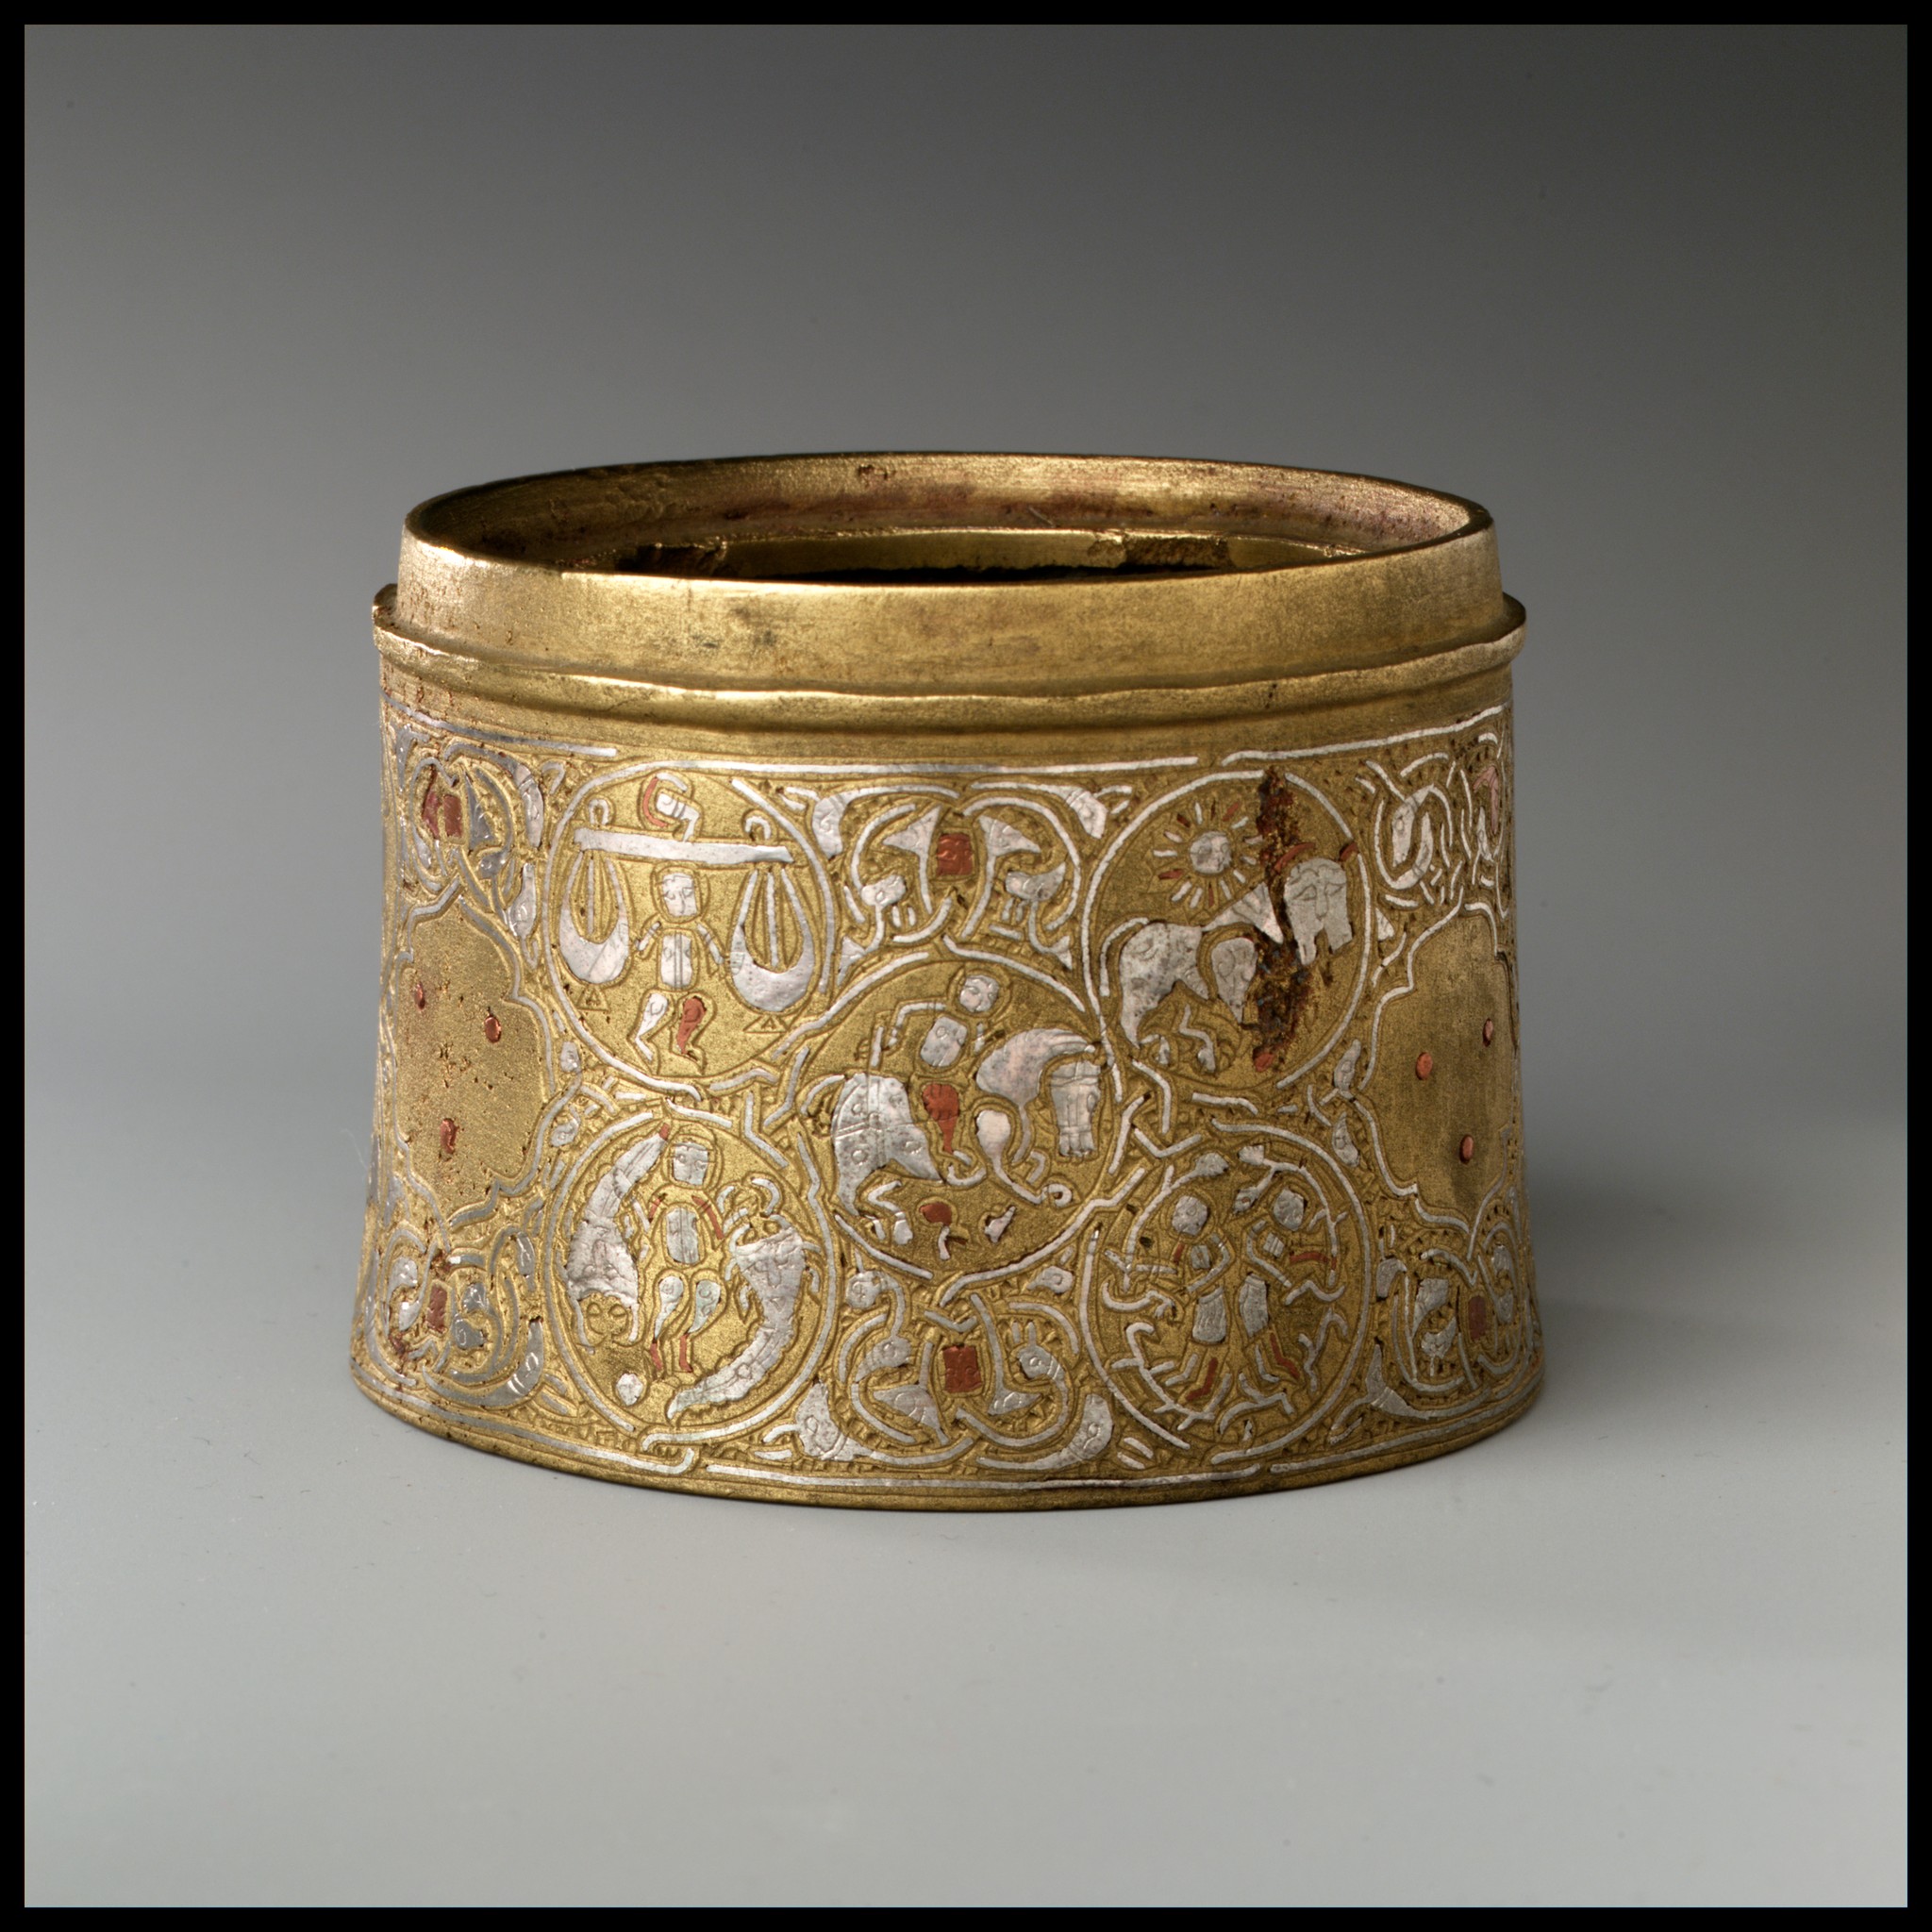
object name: inkwell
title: Inkwell with Twelve Zodiac Medallions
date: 1167-1233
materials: brass, copper, silver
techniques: casting, inlay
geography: iran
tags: zodiac